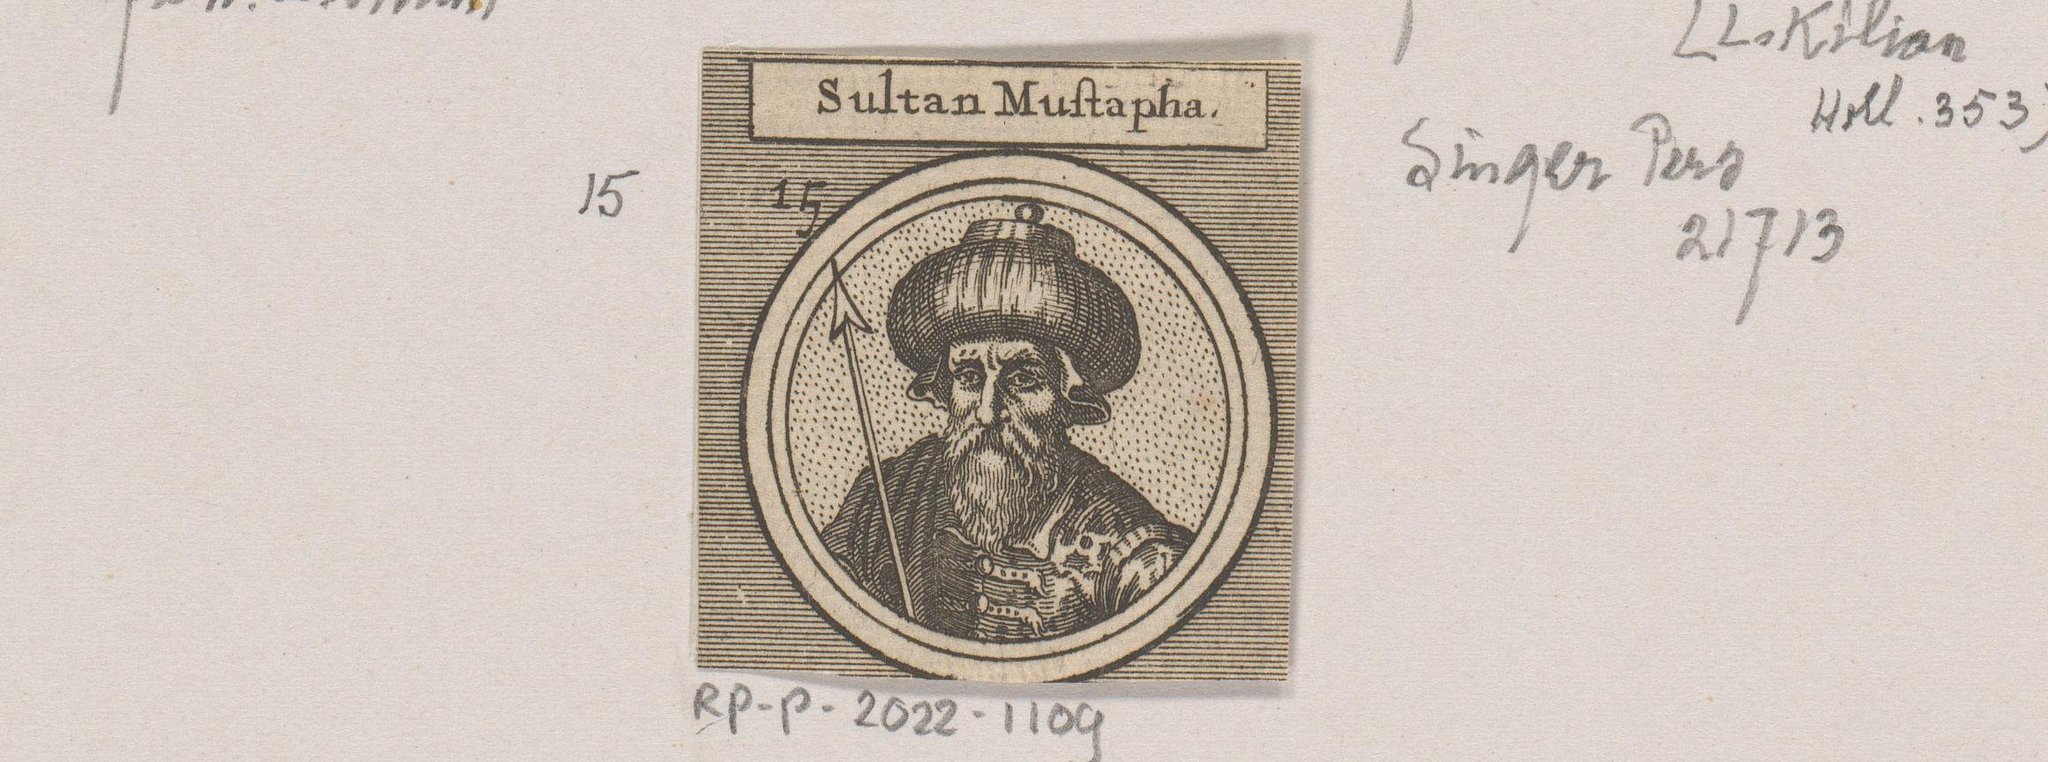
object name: book illustration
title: Portret van Mustafa I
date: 1698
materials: paper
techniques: etching, letterpress printing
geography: leiden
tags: historical persons, other sovereign (with title)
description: Prent uit: Gottfried, Johann Ludwig. Joh. Lodew. Gottfrieds Historische kronyck vervattende een nauwkeurige en volkomene beschrijvingh der aldergedenckwaerdigste geschiedenissen des weerelds (...). Leiden: Pieter van der Aa, 1698.